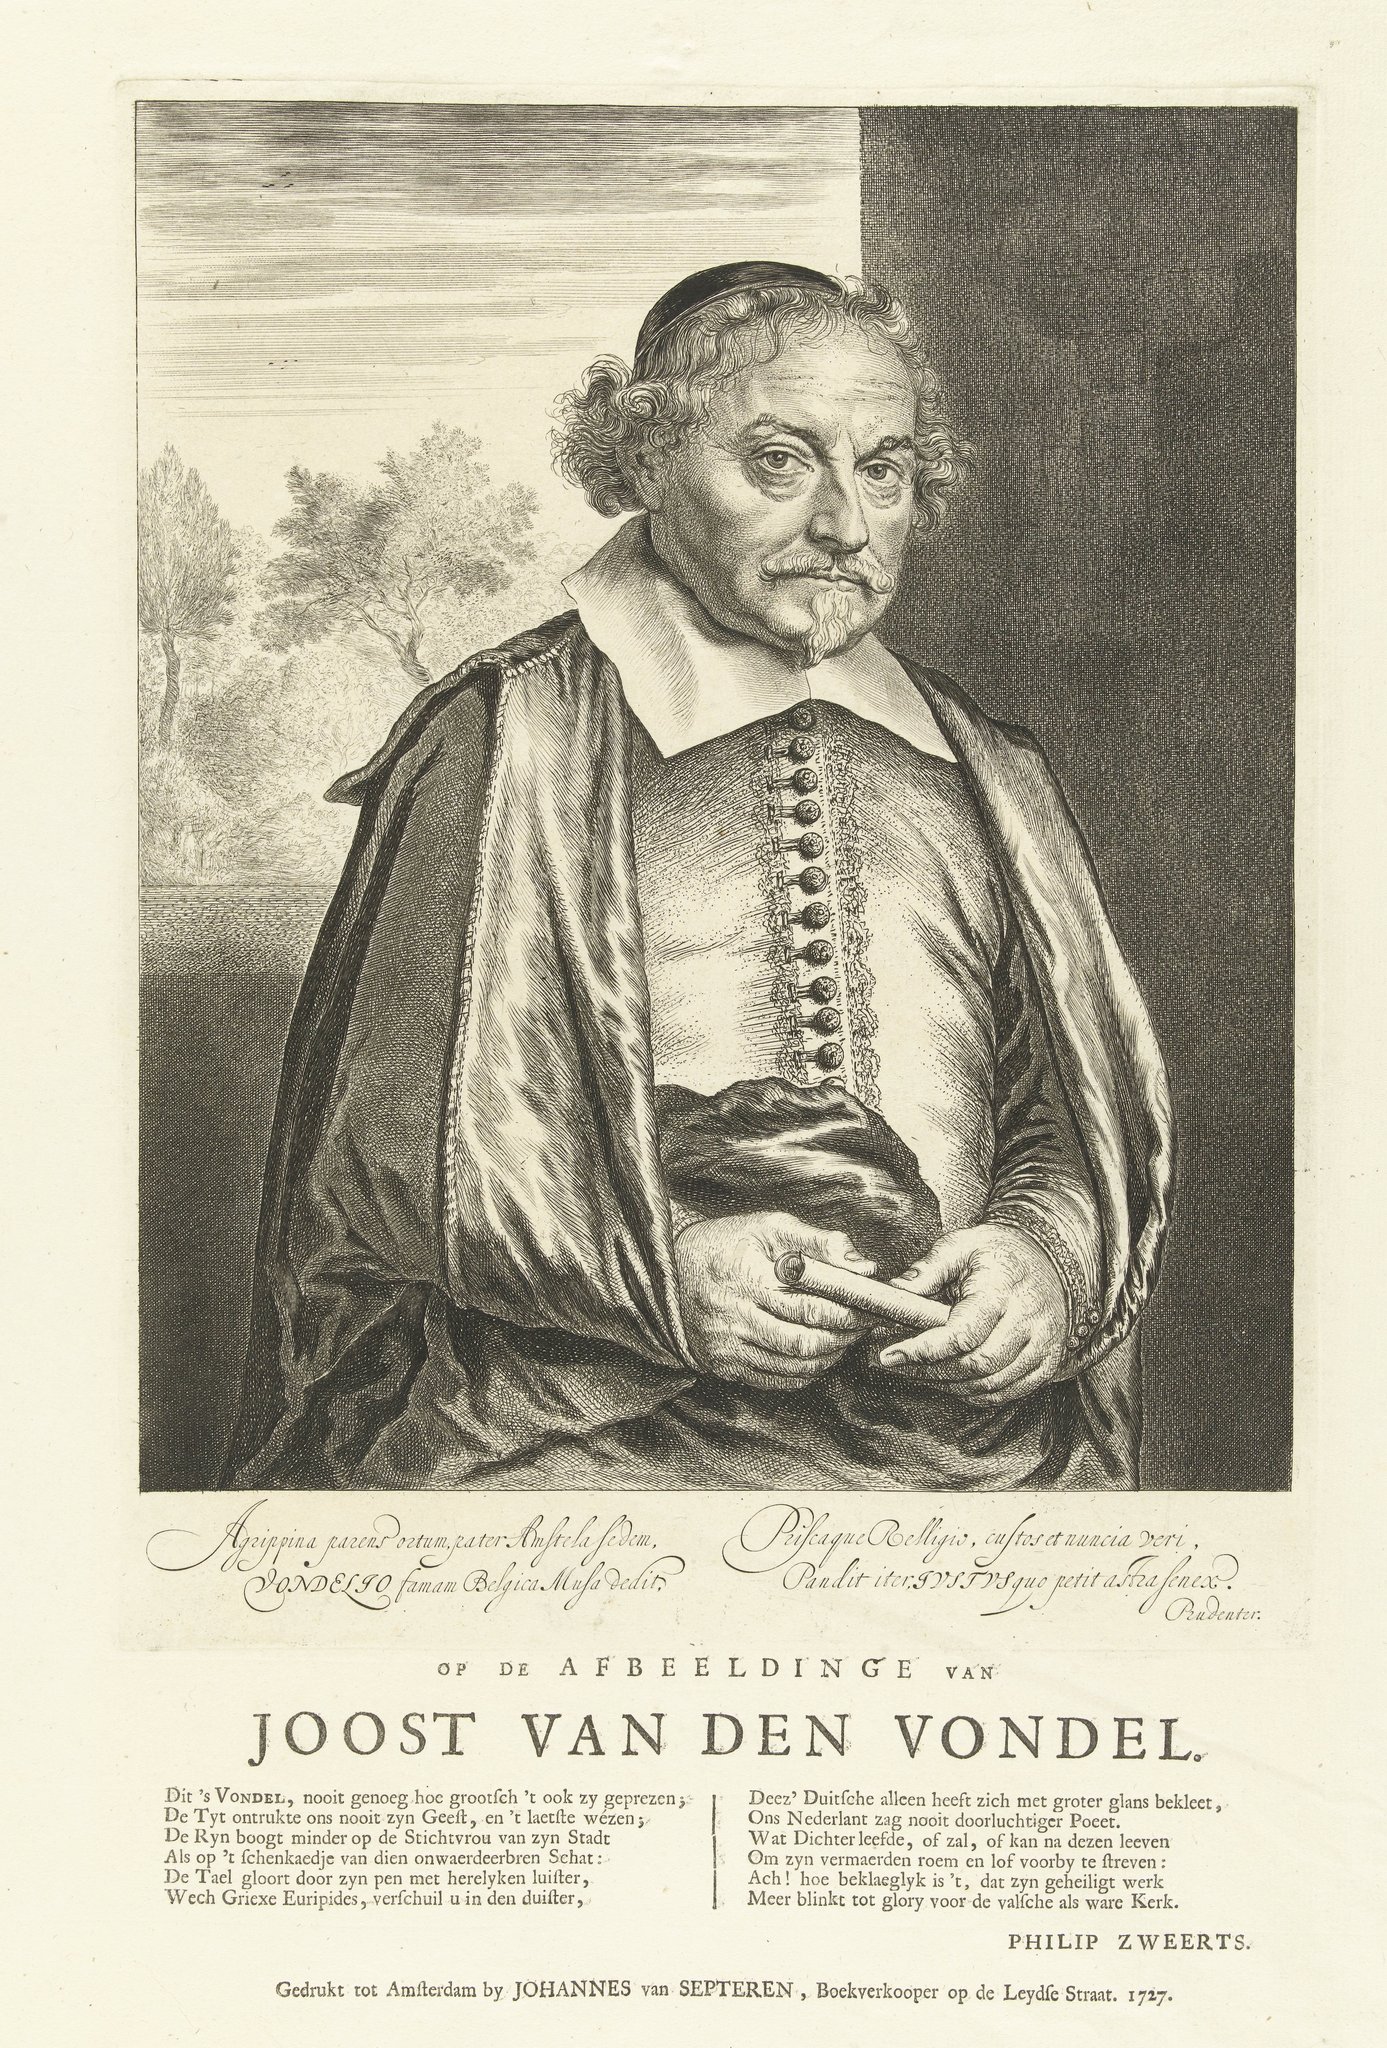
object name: print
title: Portret van Joost van den Vondel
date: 1644-1650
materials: paper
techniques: etching, letterpress printing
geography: leidsestraat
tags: cologne, amsterdam, joost van den vondel, portrait of a writer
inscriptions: inscription: ‘Agrippina parens ostum pater Amsterla sedem VONDELIO famam Belgica Musa dedit, Priscaque Relligio, custos et nuncia veri, pandit iter, JUSTUSquo petit astra senex. Prudenter’, collector's mark: Lugt 2233, inscription: ‘op de afbeelding van Joost van den Vondel. Dit is Vondel (...) valse als ware kerk. Philip Zweerts’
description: Portret van de schrijver en dichter Joost van dan Vondel, ten halven lijve, met een rol papier in zijn handen. Een doorkijk naar een landschap met bomen op de achtergrond. Onder het portret een vierregelige tekst in het Latijn. Onder de prent een gedicht van Philip Zweerts gedrukt.